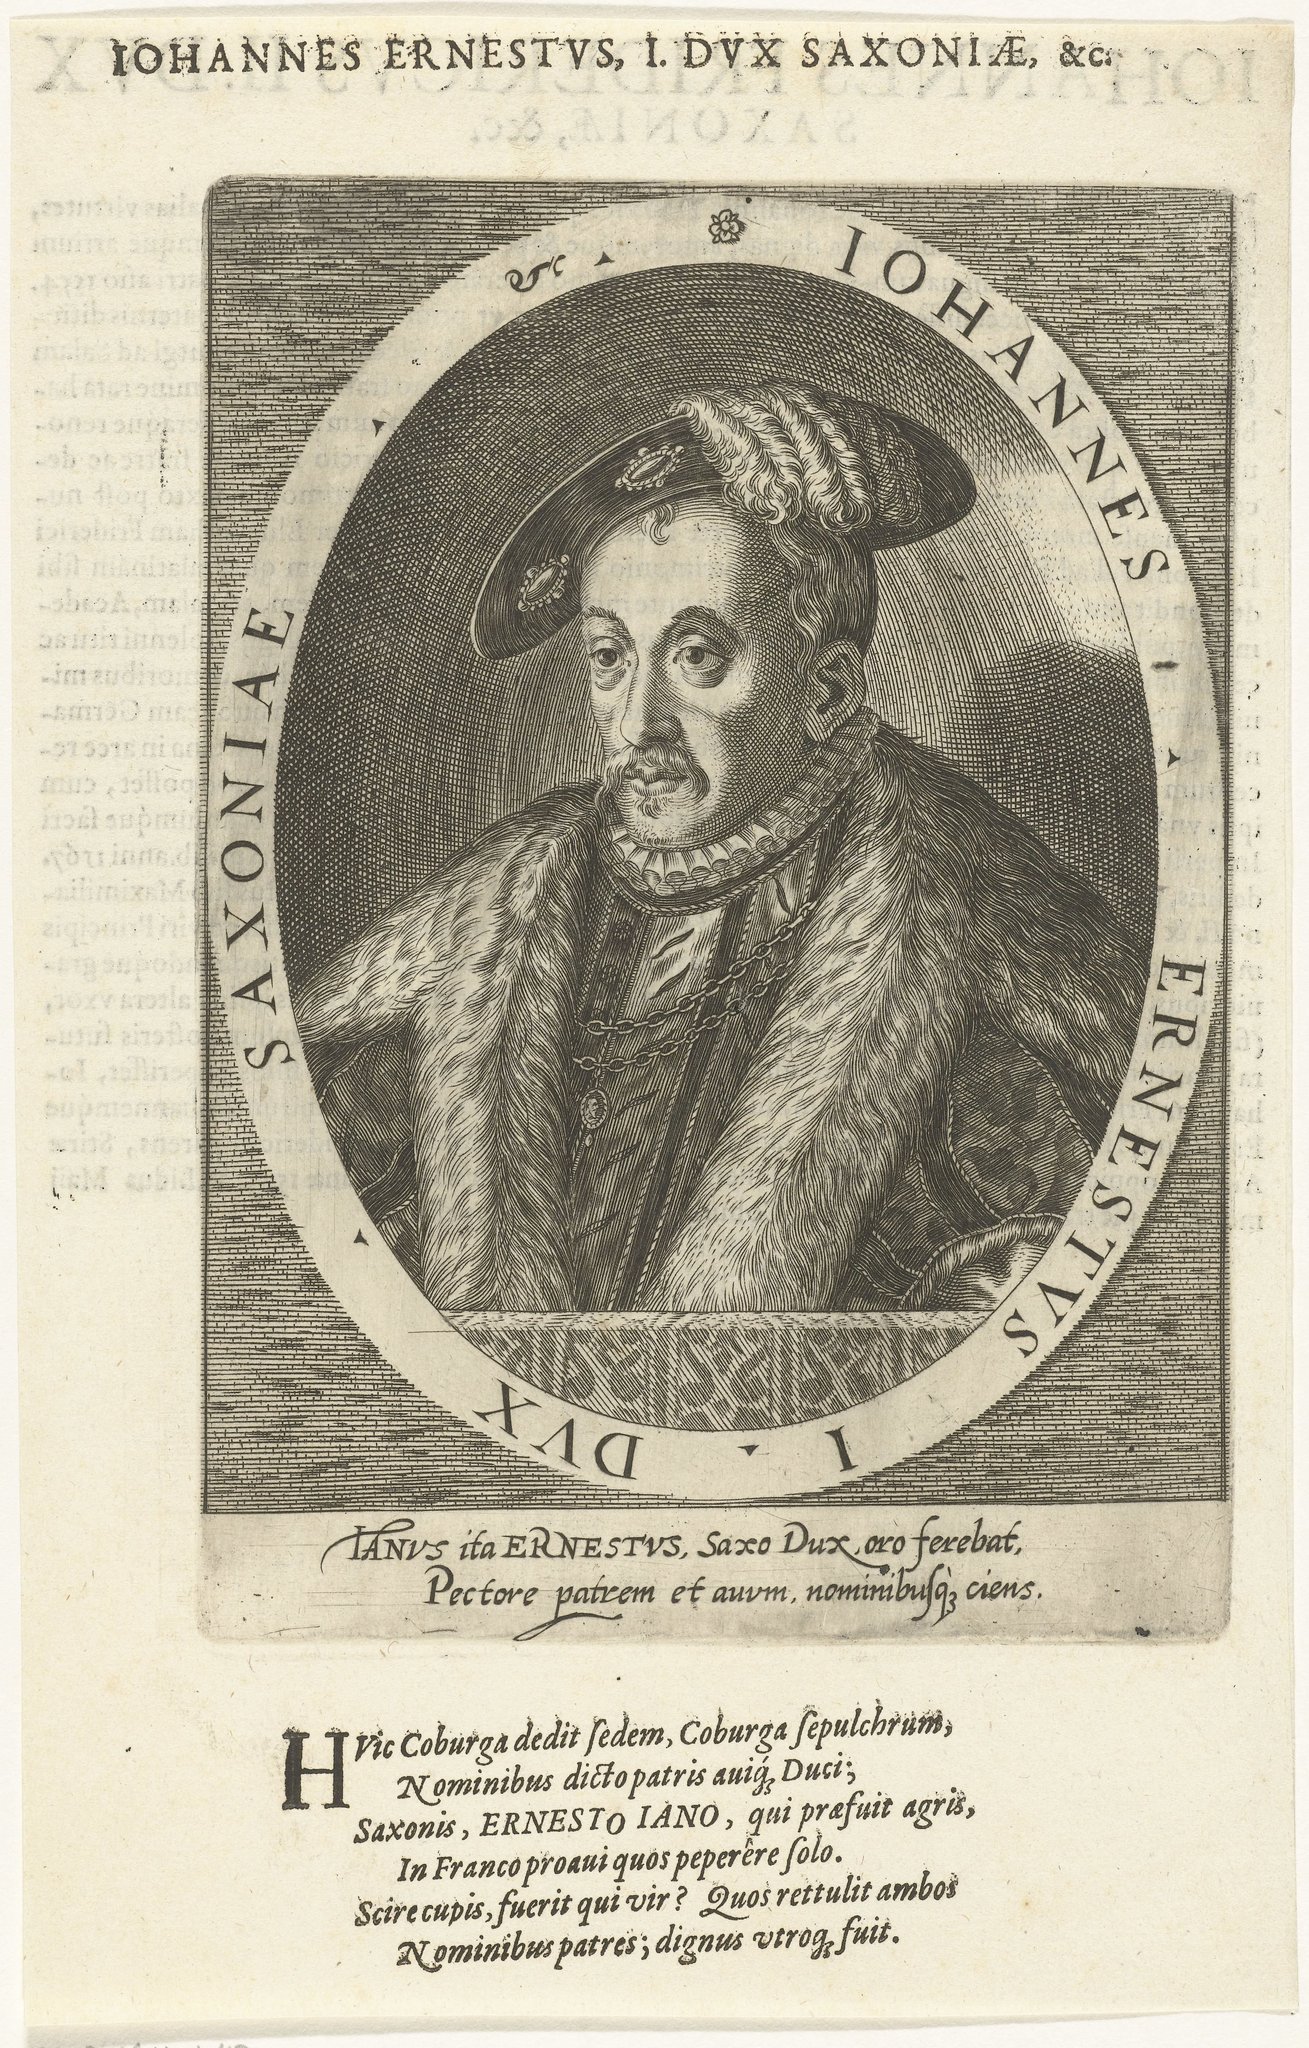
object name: print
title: Saxoniae Ducum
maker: dominicus custos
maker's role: print maker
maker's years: 1560-1615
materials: paper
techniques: engraving, letterpress printing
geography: augsburg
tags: coburg, johan ernst (hertog van saksen-coburg)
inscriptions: collector's mark: Lugt 2228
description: Illustratie uit: Saxoniae Ducum. Caesarib. Creand. VIIVirum; et caeterorum A Friderico I. Ad Christianum II. Fratres Et Agnatos, Genuinae effig. Augsburg: D. Custos en M. Manger, 1601, of latere editie.